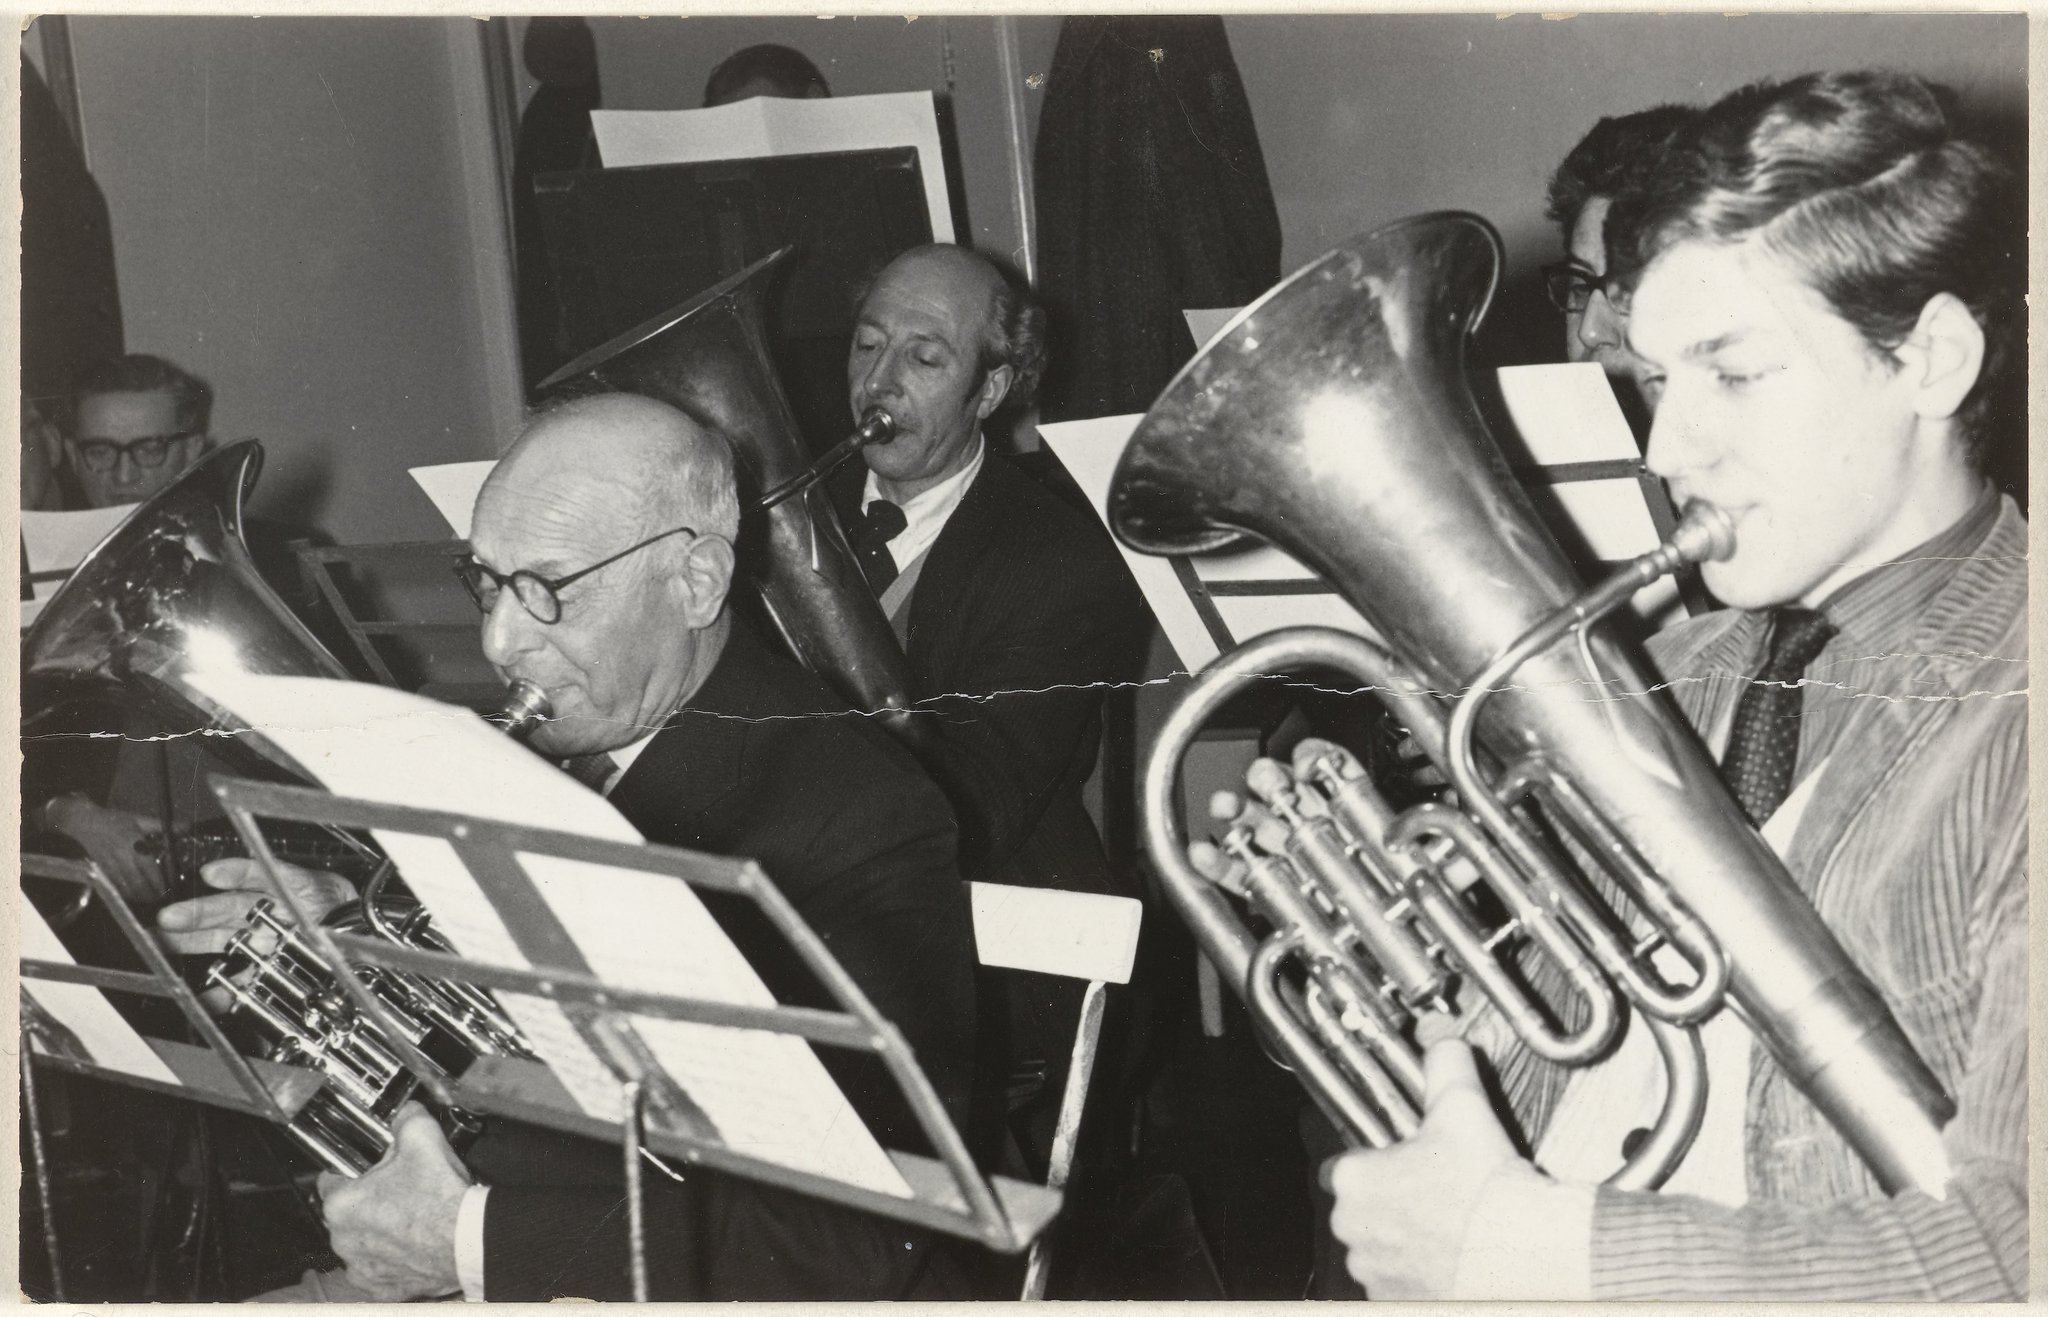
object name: photograph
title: Portret van een groep blazers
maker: Anonymous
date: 1930-1940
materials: photographic support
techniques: gelatin silver print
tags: wind instruments, anonymous historical persons portrayed in a group, in a group-portrait